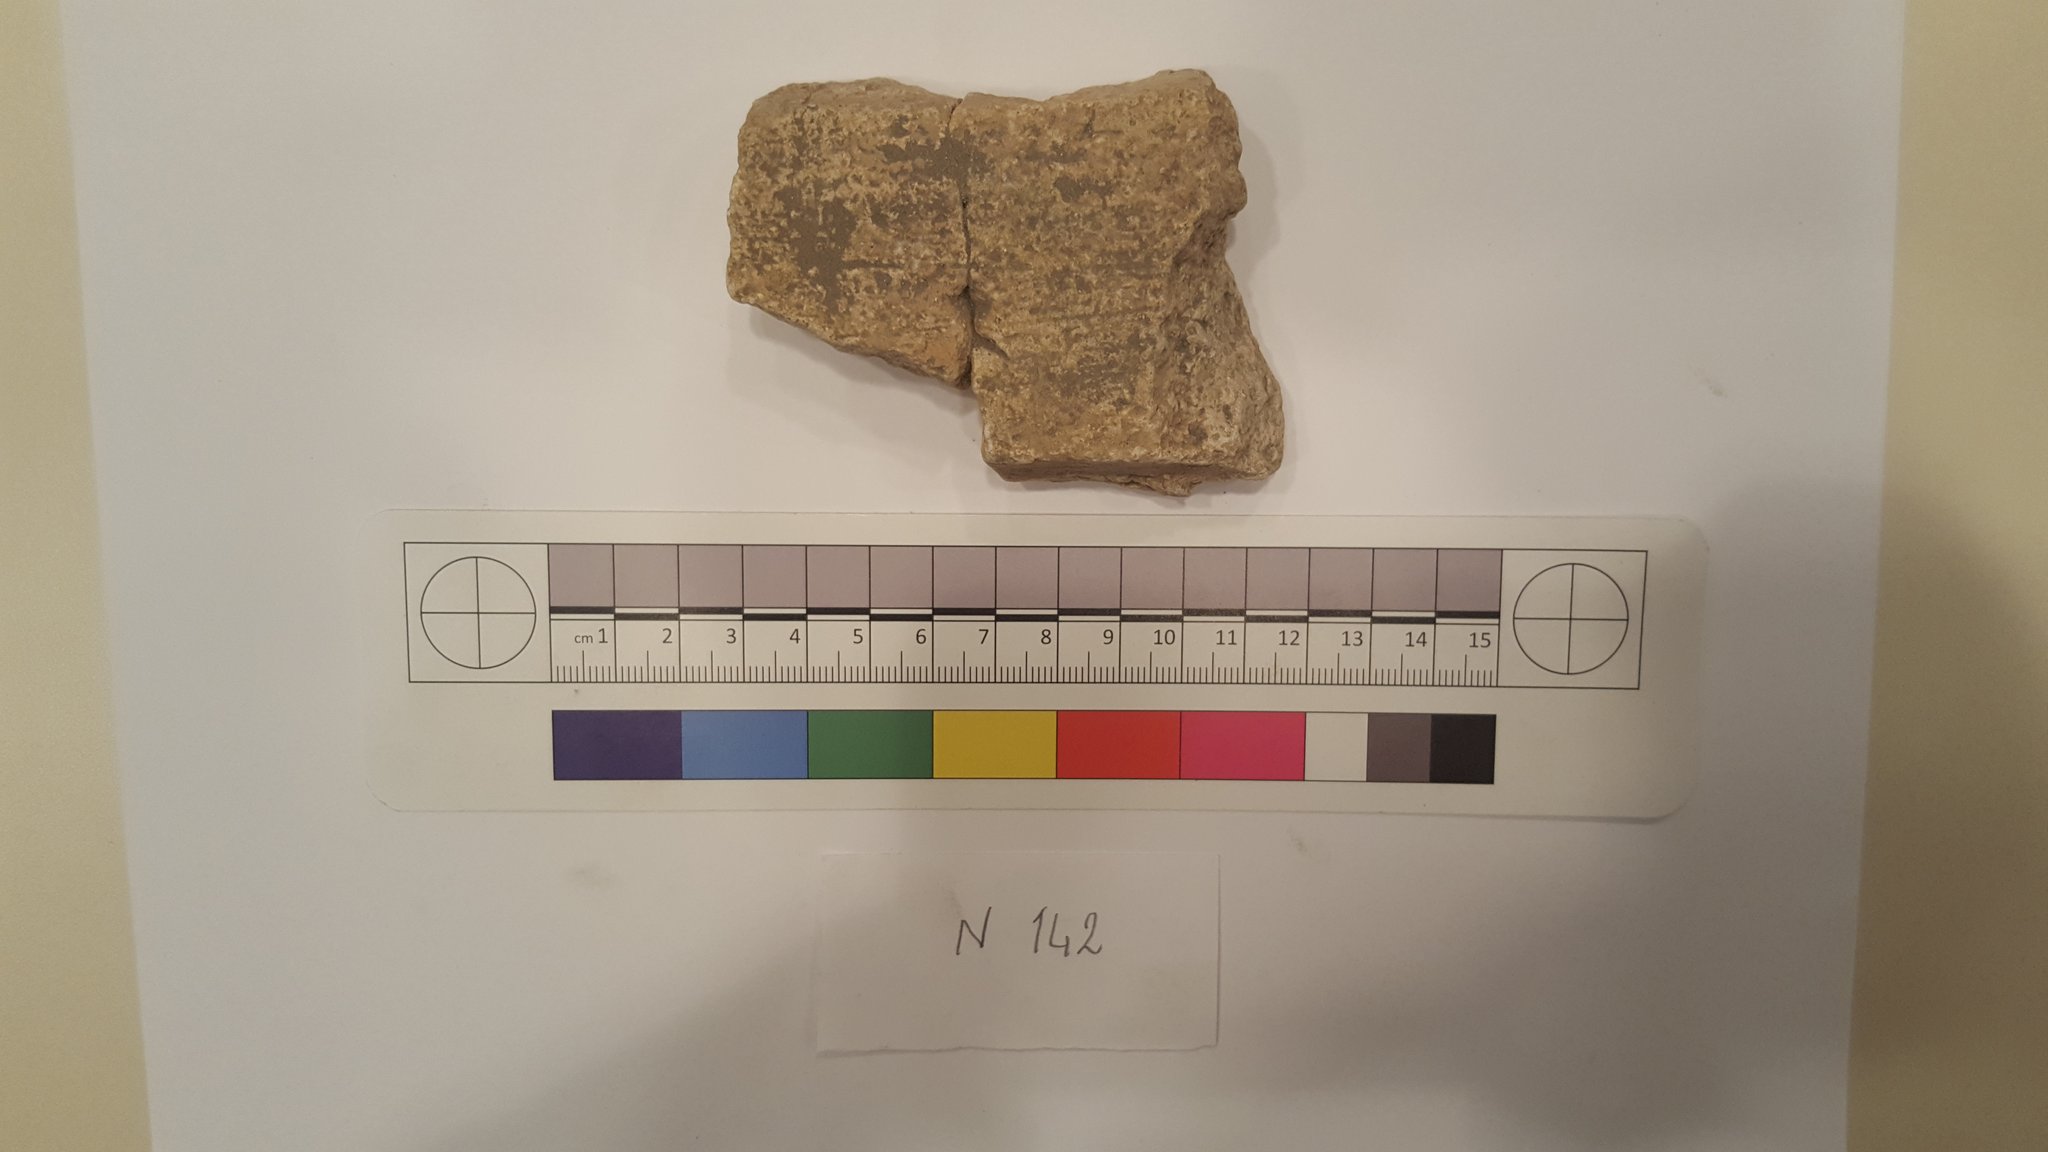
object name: fragment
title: Stucco Fragment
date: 701-1200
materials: plaster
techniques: carving, painting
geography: iran